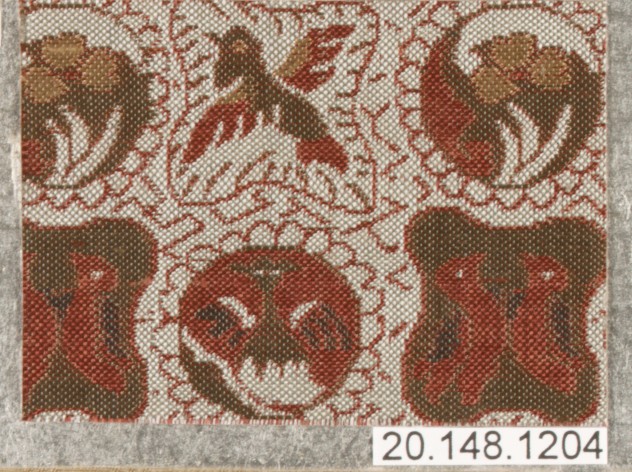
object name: piece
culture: japanese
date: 1701-1800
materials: silk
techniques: compound weave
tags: birds